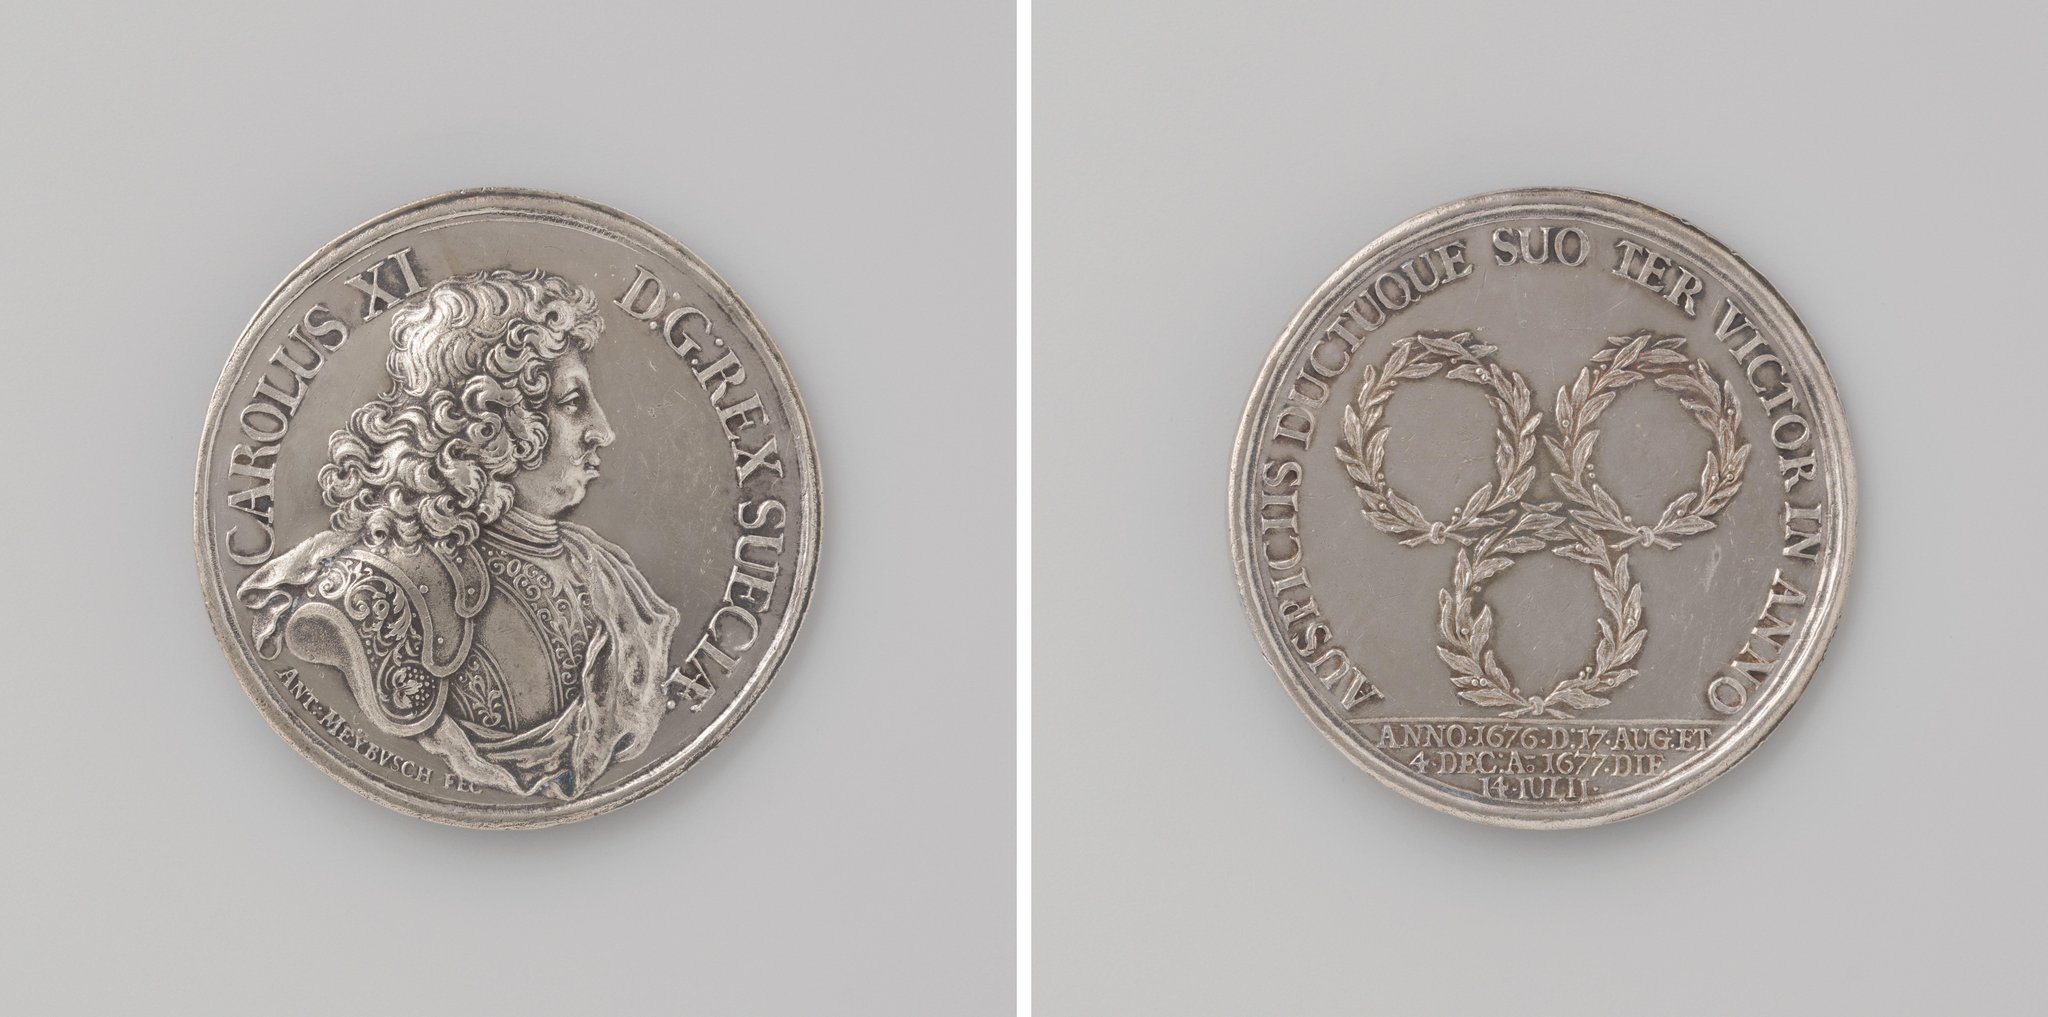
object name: history medal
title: Overwinningen op de Denen, ter ere van Karel XI van Zweden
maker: anton meybusch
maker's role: medailleur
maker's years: 1645-1702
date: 1677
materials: silver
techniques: striking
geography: stockholm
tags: stockholm, koning, karel xi (koning van zweden), faeröer, zweden, noordse oorlogen, schonense oorlog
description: Zilveren penning. Voorzijde: borststuk man binnen omschrift. Keerzijde: drie bevochten zegekransen binnen omschrift.